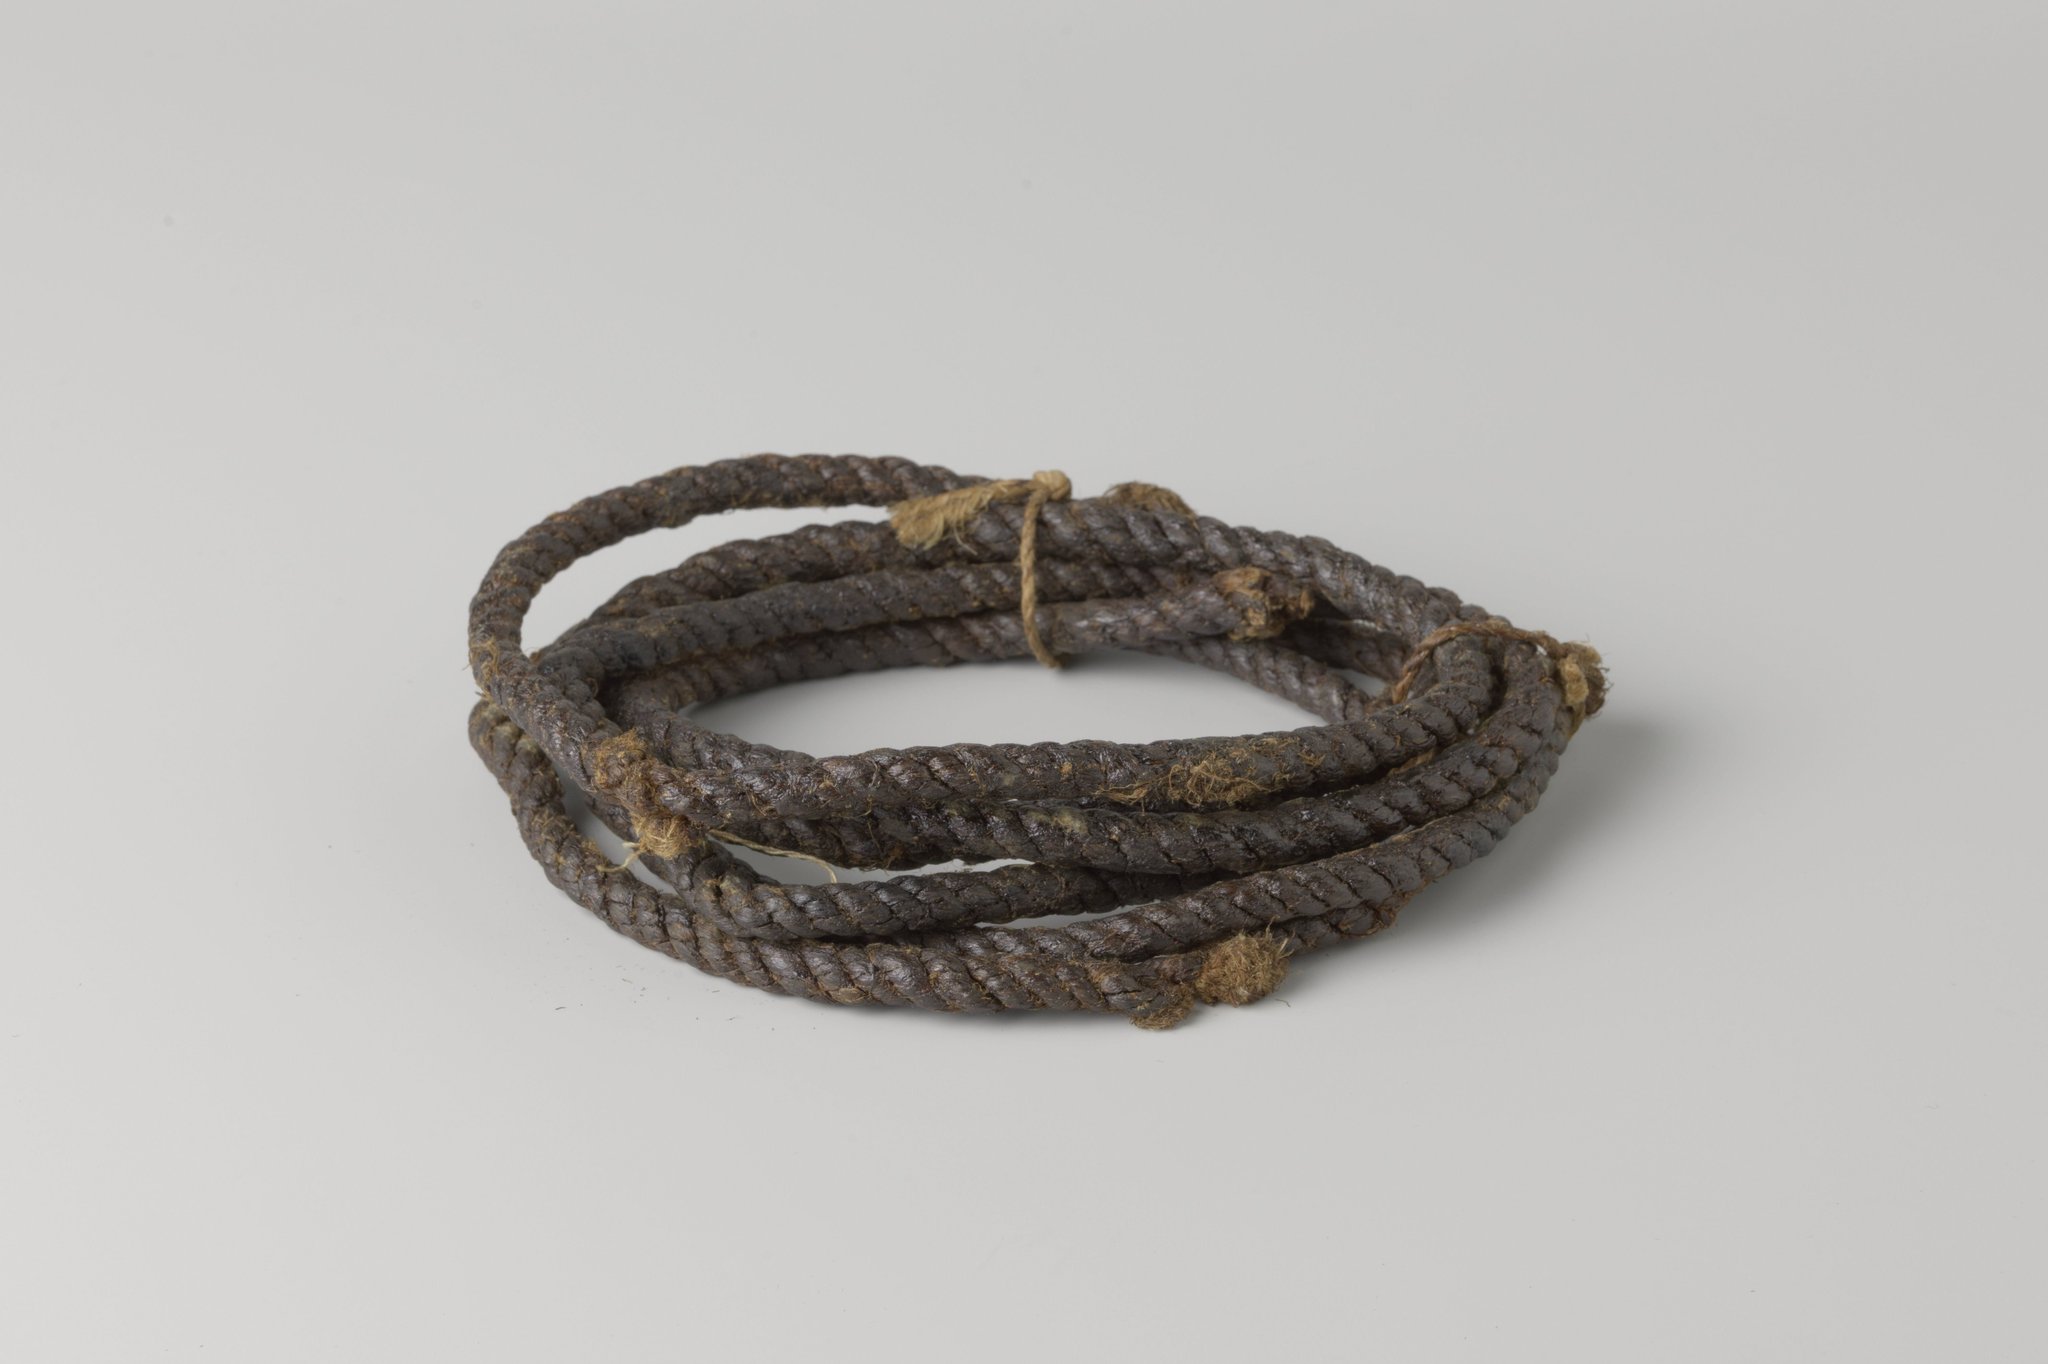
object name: rope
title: Piktouw, in rol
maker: Anonymous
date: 1590-1596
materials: fiber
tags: willem barendsz., amsterdam, jacob van heemskerck